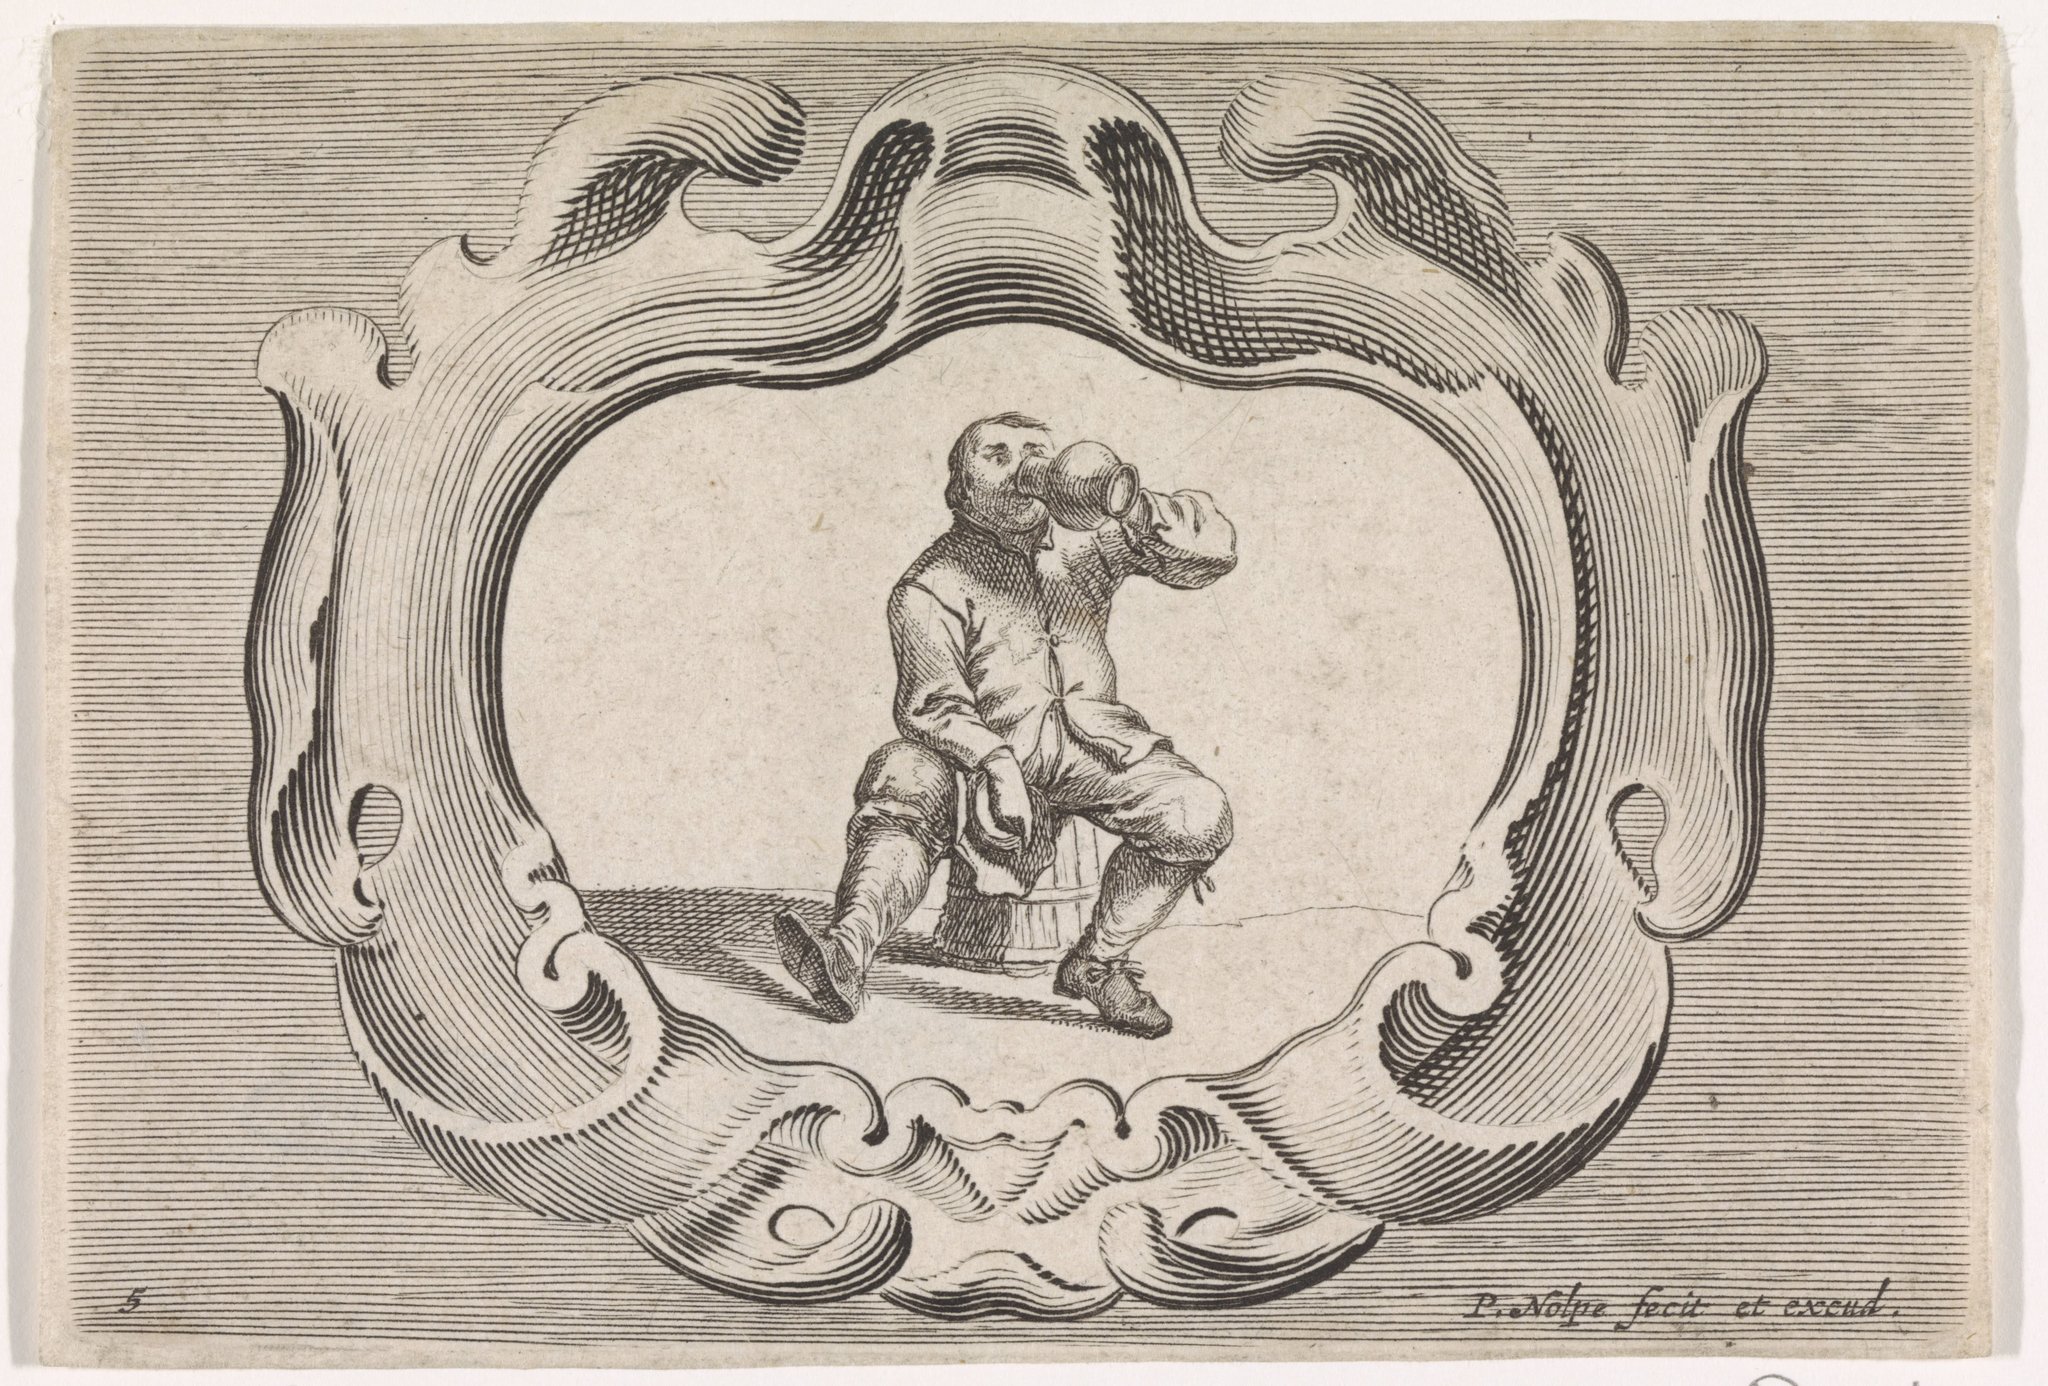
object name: print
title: Drinkende boer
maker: pieter nolpe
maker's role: draughtsman, print maker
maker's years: 1613-1653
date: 1623-1653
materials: paper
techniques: engraving, etching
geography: amsterdam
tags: jar, jug (used as drinking-vessel), farmers, drinking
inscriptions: collector's mark: Lugt 2228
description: Een boer, zittend op een houten emmer, drinkt uit een kruik. In zijn andere hand houdt hij zijn hoed. De voorstelling is gevat in een schulpvormig cartouche. Prent maakt deel uit van een serie met scènes uit het boerenleven.